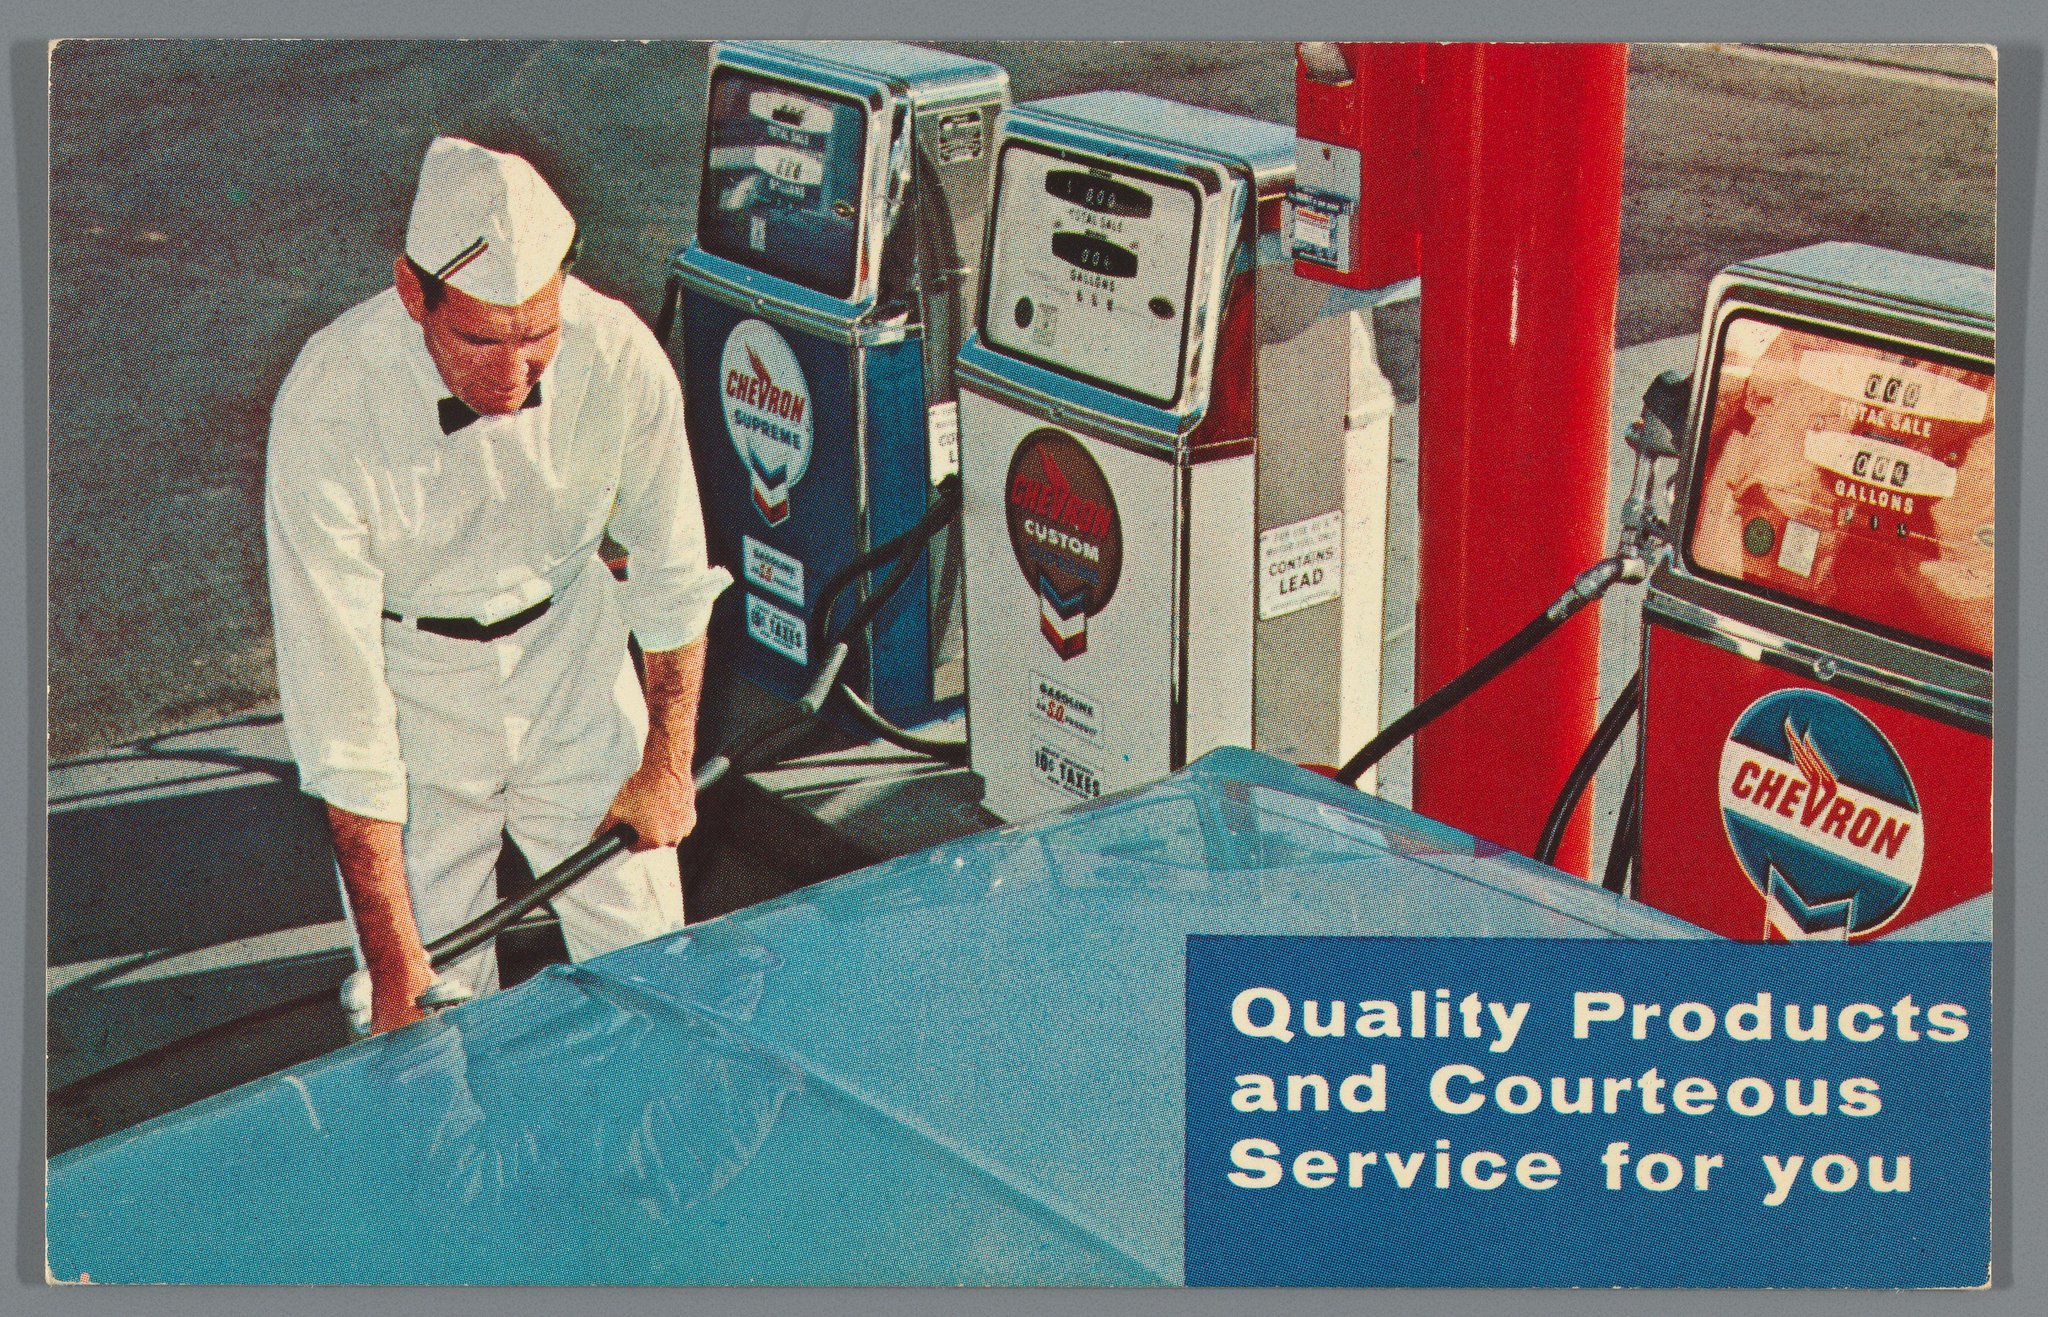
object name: ansichtkaart, prentbriefkaart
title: Quality Products and Courteous Service for you , Chevron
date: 1955-1960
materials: paper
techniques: offset printed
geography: united states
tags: united states of america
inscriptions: inscription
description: Servicekaart in de vorm van prentbriefkaart.